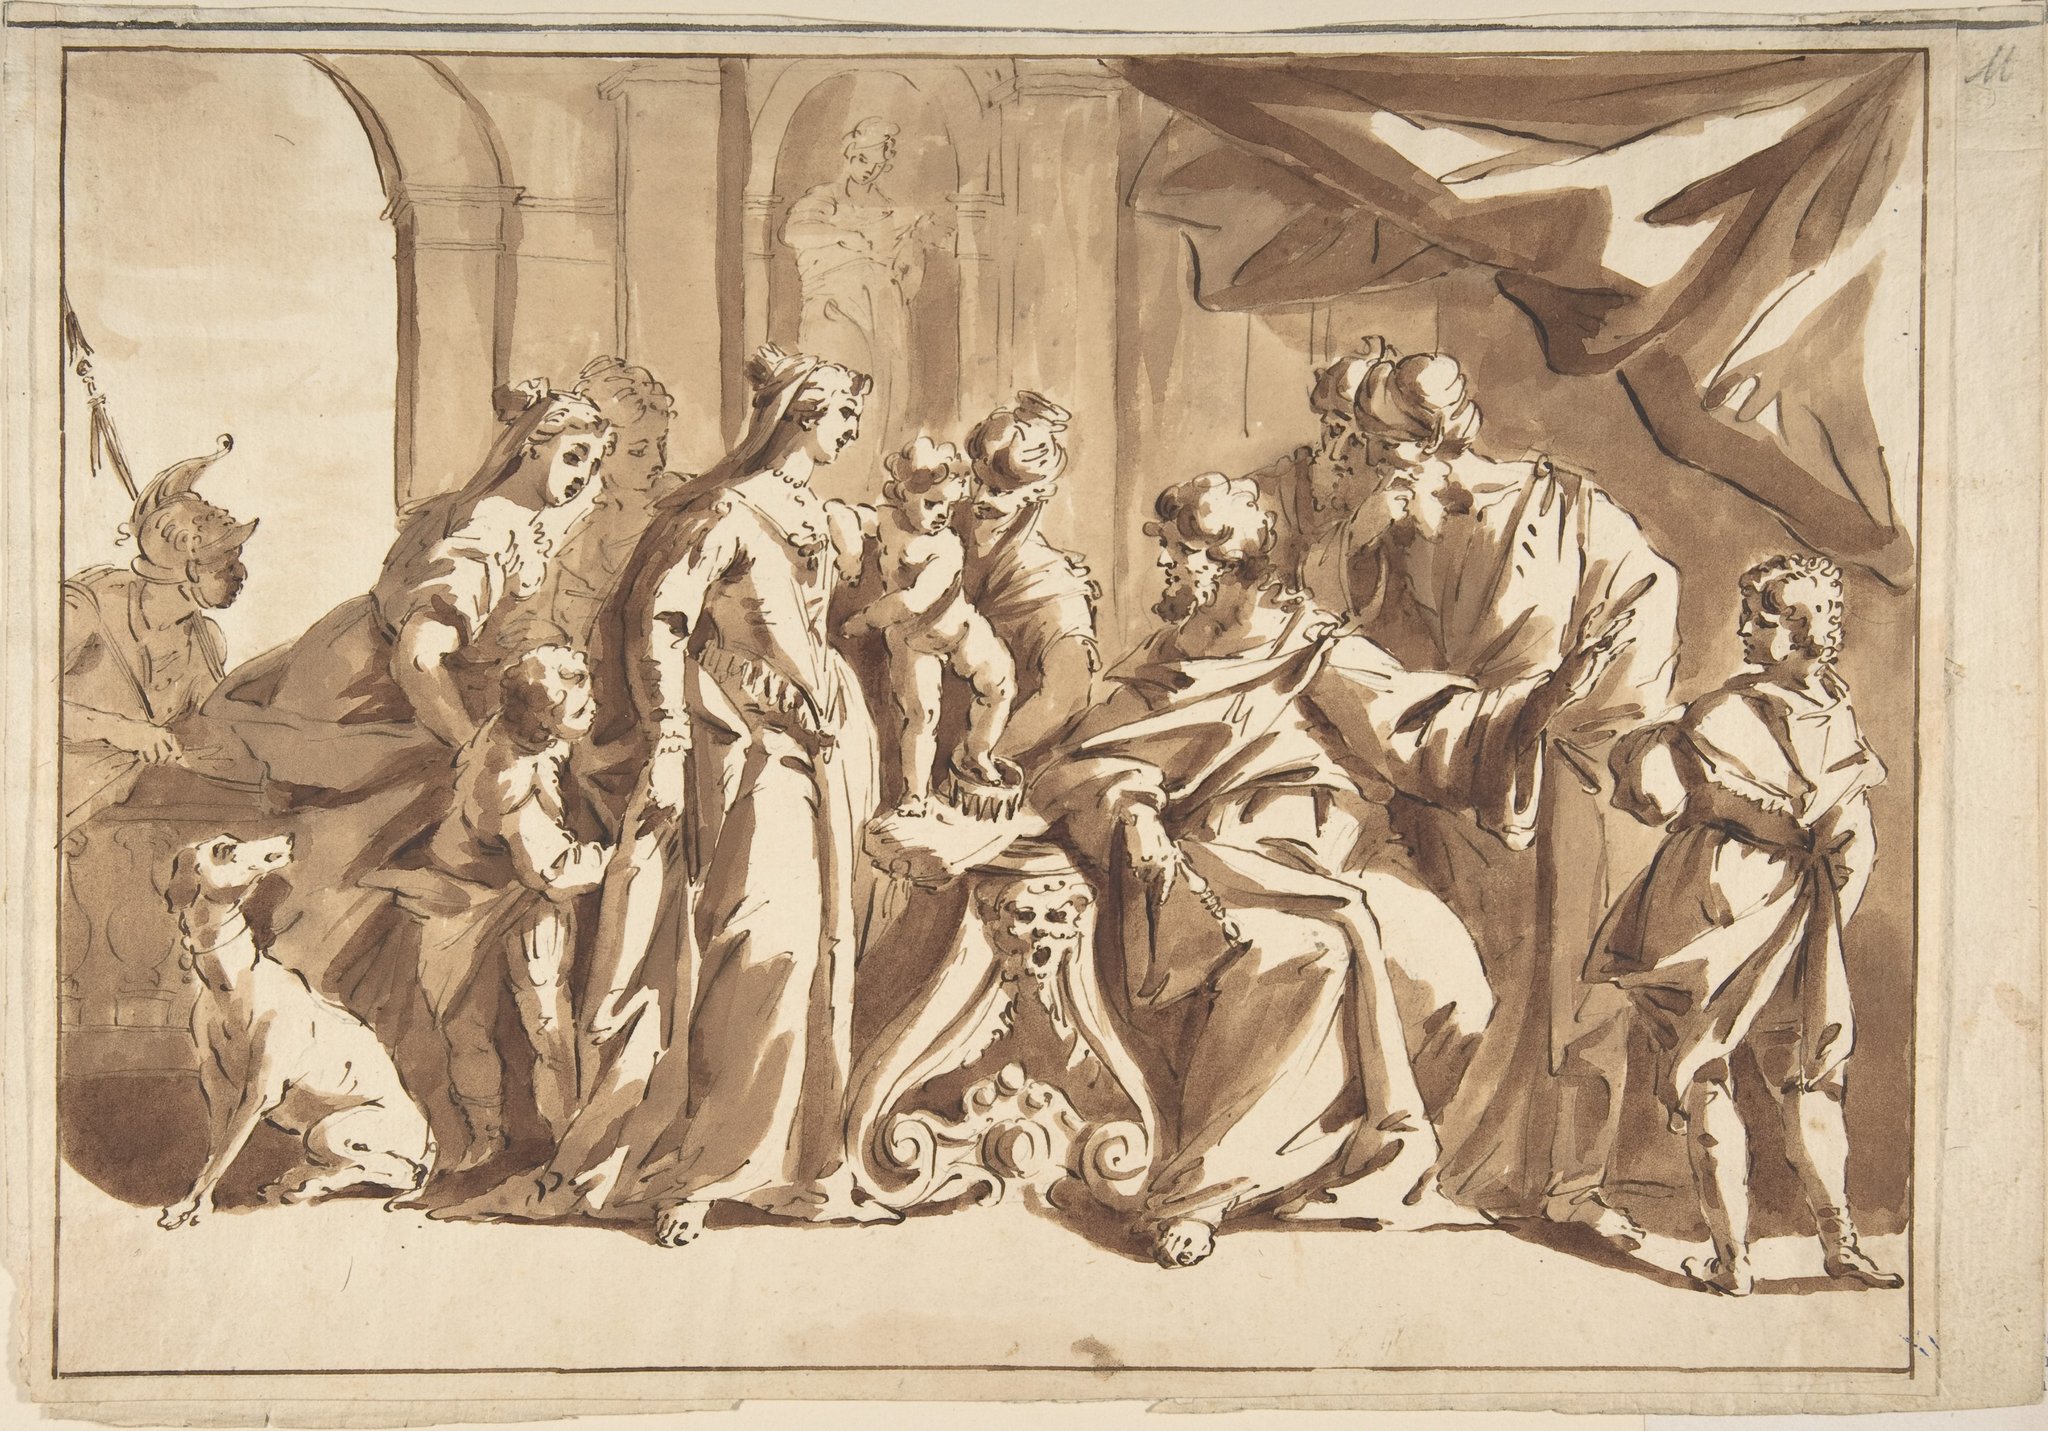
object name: drawing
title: Moses Trampling on Pharaoh's Crown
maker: anonymous, italian, venetian, 18th century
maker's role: artist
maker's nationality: italian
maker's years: 1700-1800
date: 1701-1800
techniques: brush, pen, wash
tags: children,men,women,dogs,moses